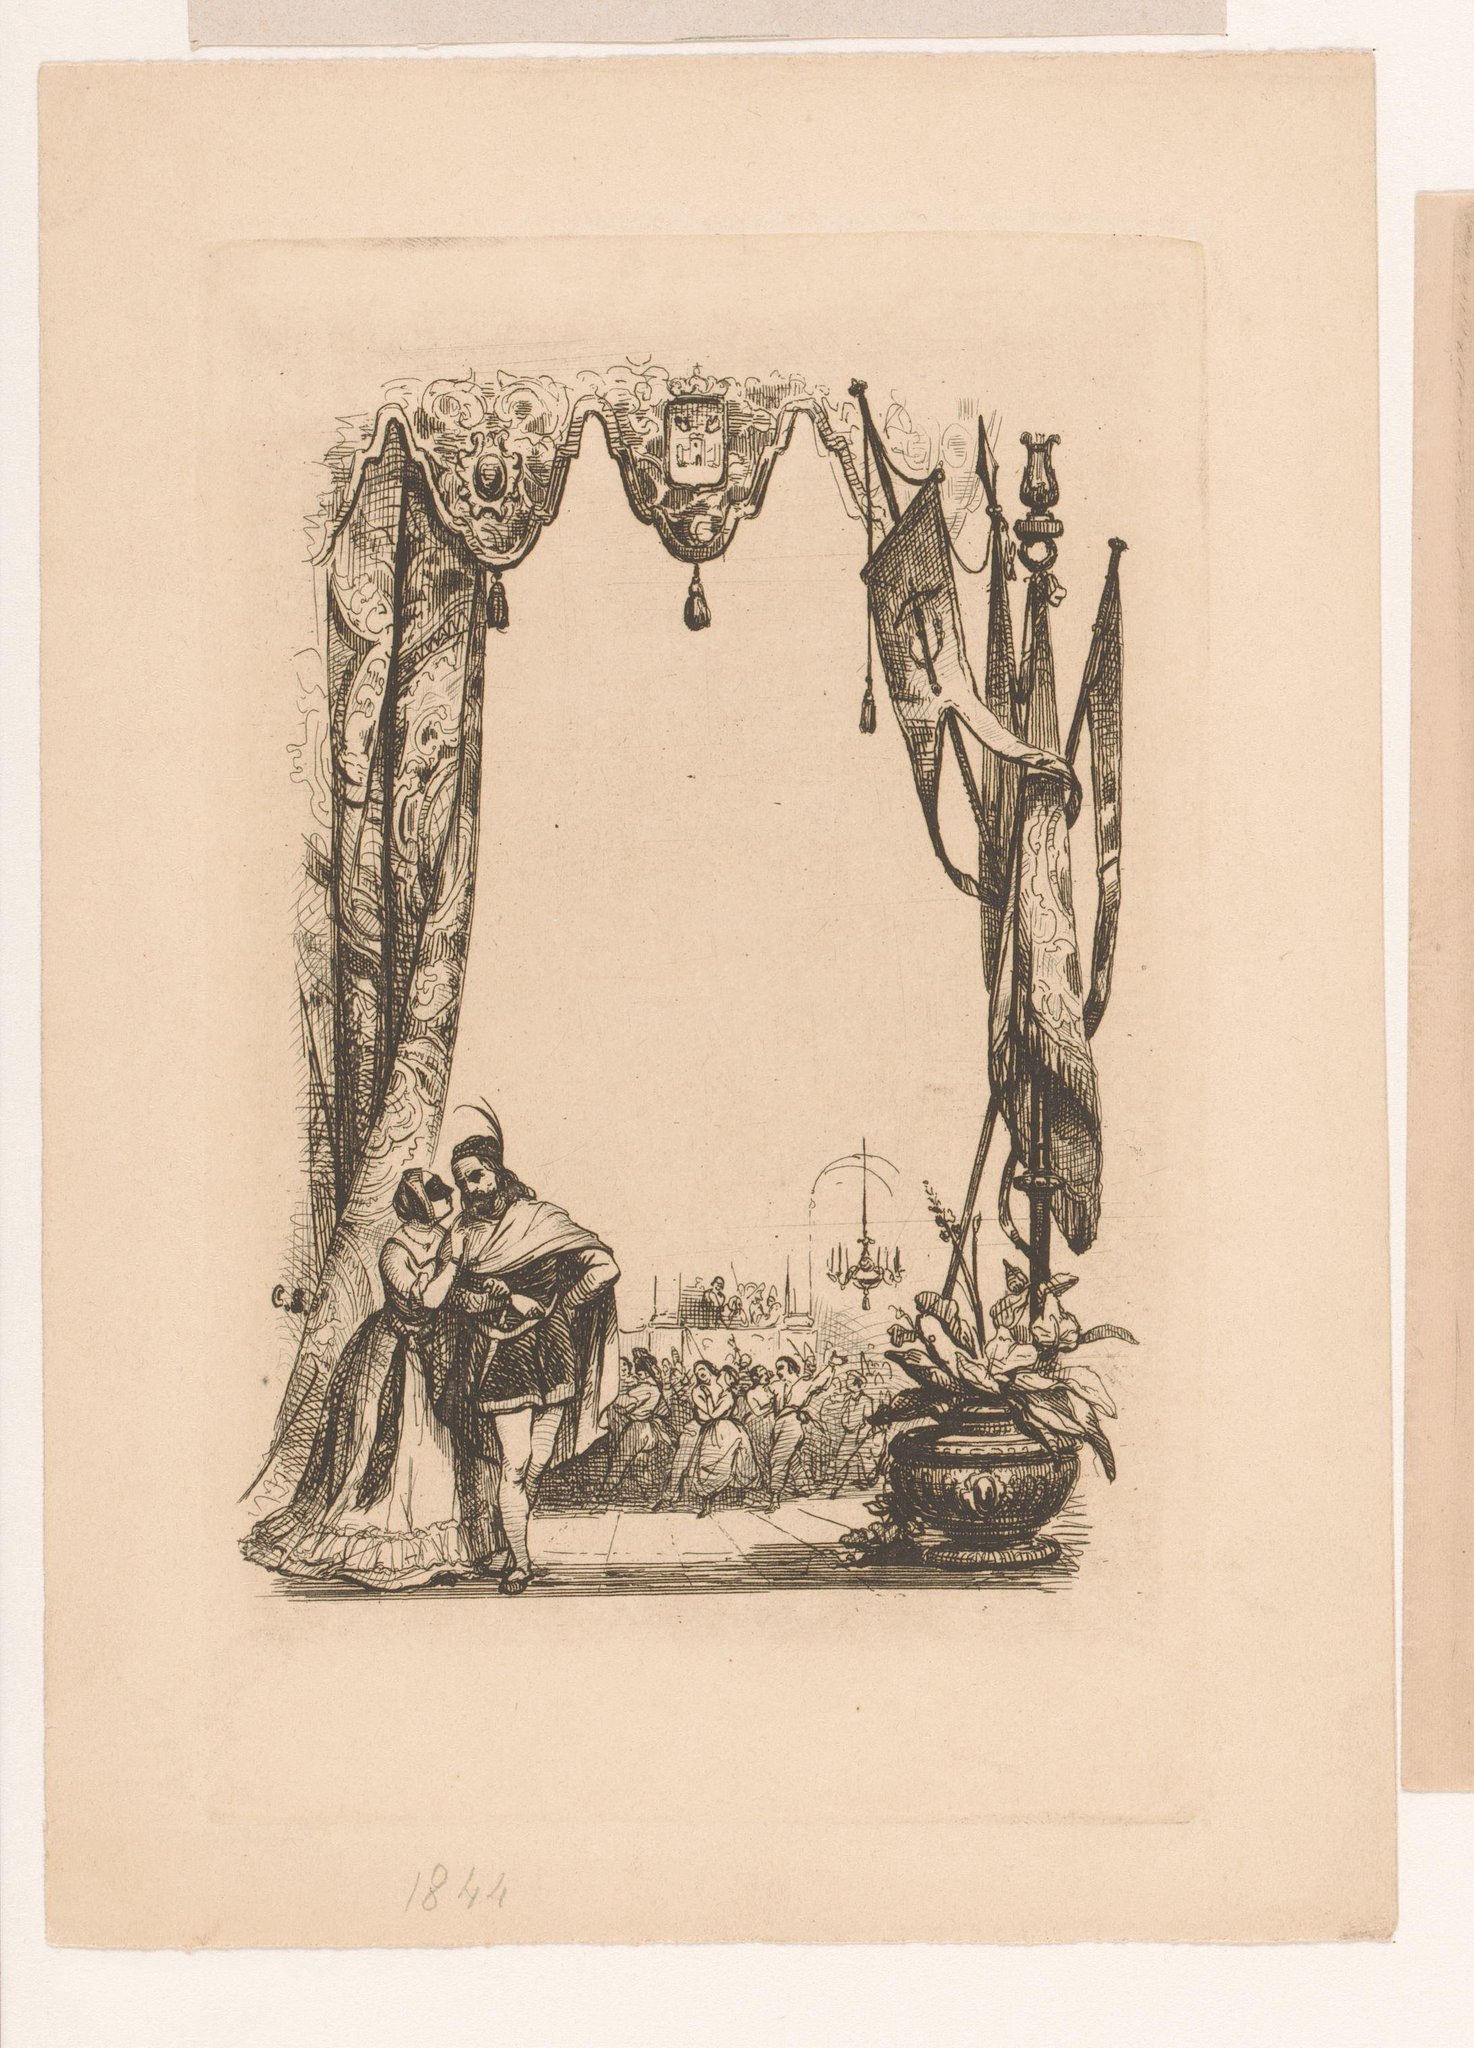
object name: print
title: Man en gemaskerde vrouw bij een danszaal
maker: corneille seghers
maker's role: draughtsman, print maker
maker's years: 1814-1869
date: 1844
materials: paper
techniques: drypoint, etching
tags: masquerade, masked ball, group dancing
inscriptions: collector's mark: Lugt 2228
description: Deze prent is later gebruikt als een programma en een uitnodiging van de Société Guillaume-Tell. Zie RP-P-1888-A-13653 en RP-P-1913-2864 voor de twee verschillende staten met de letter.